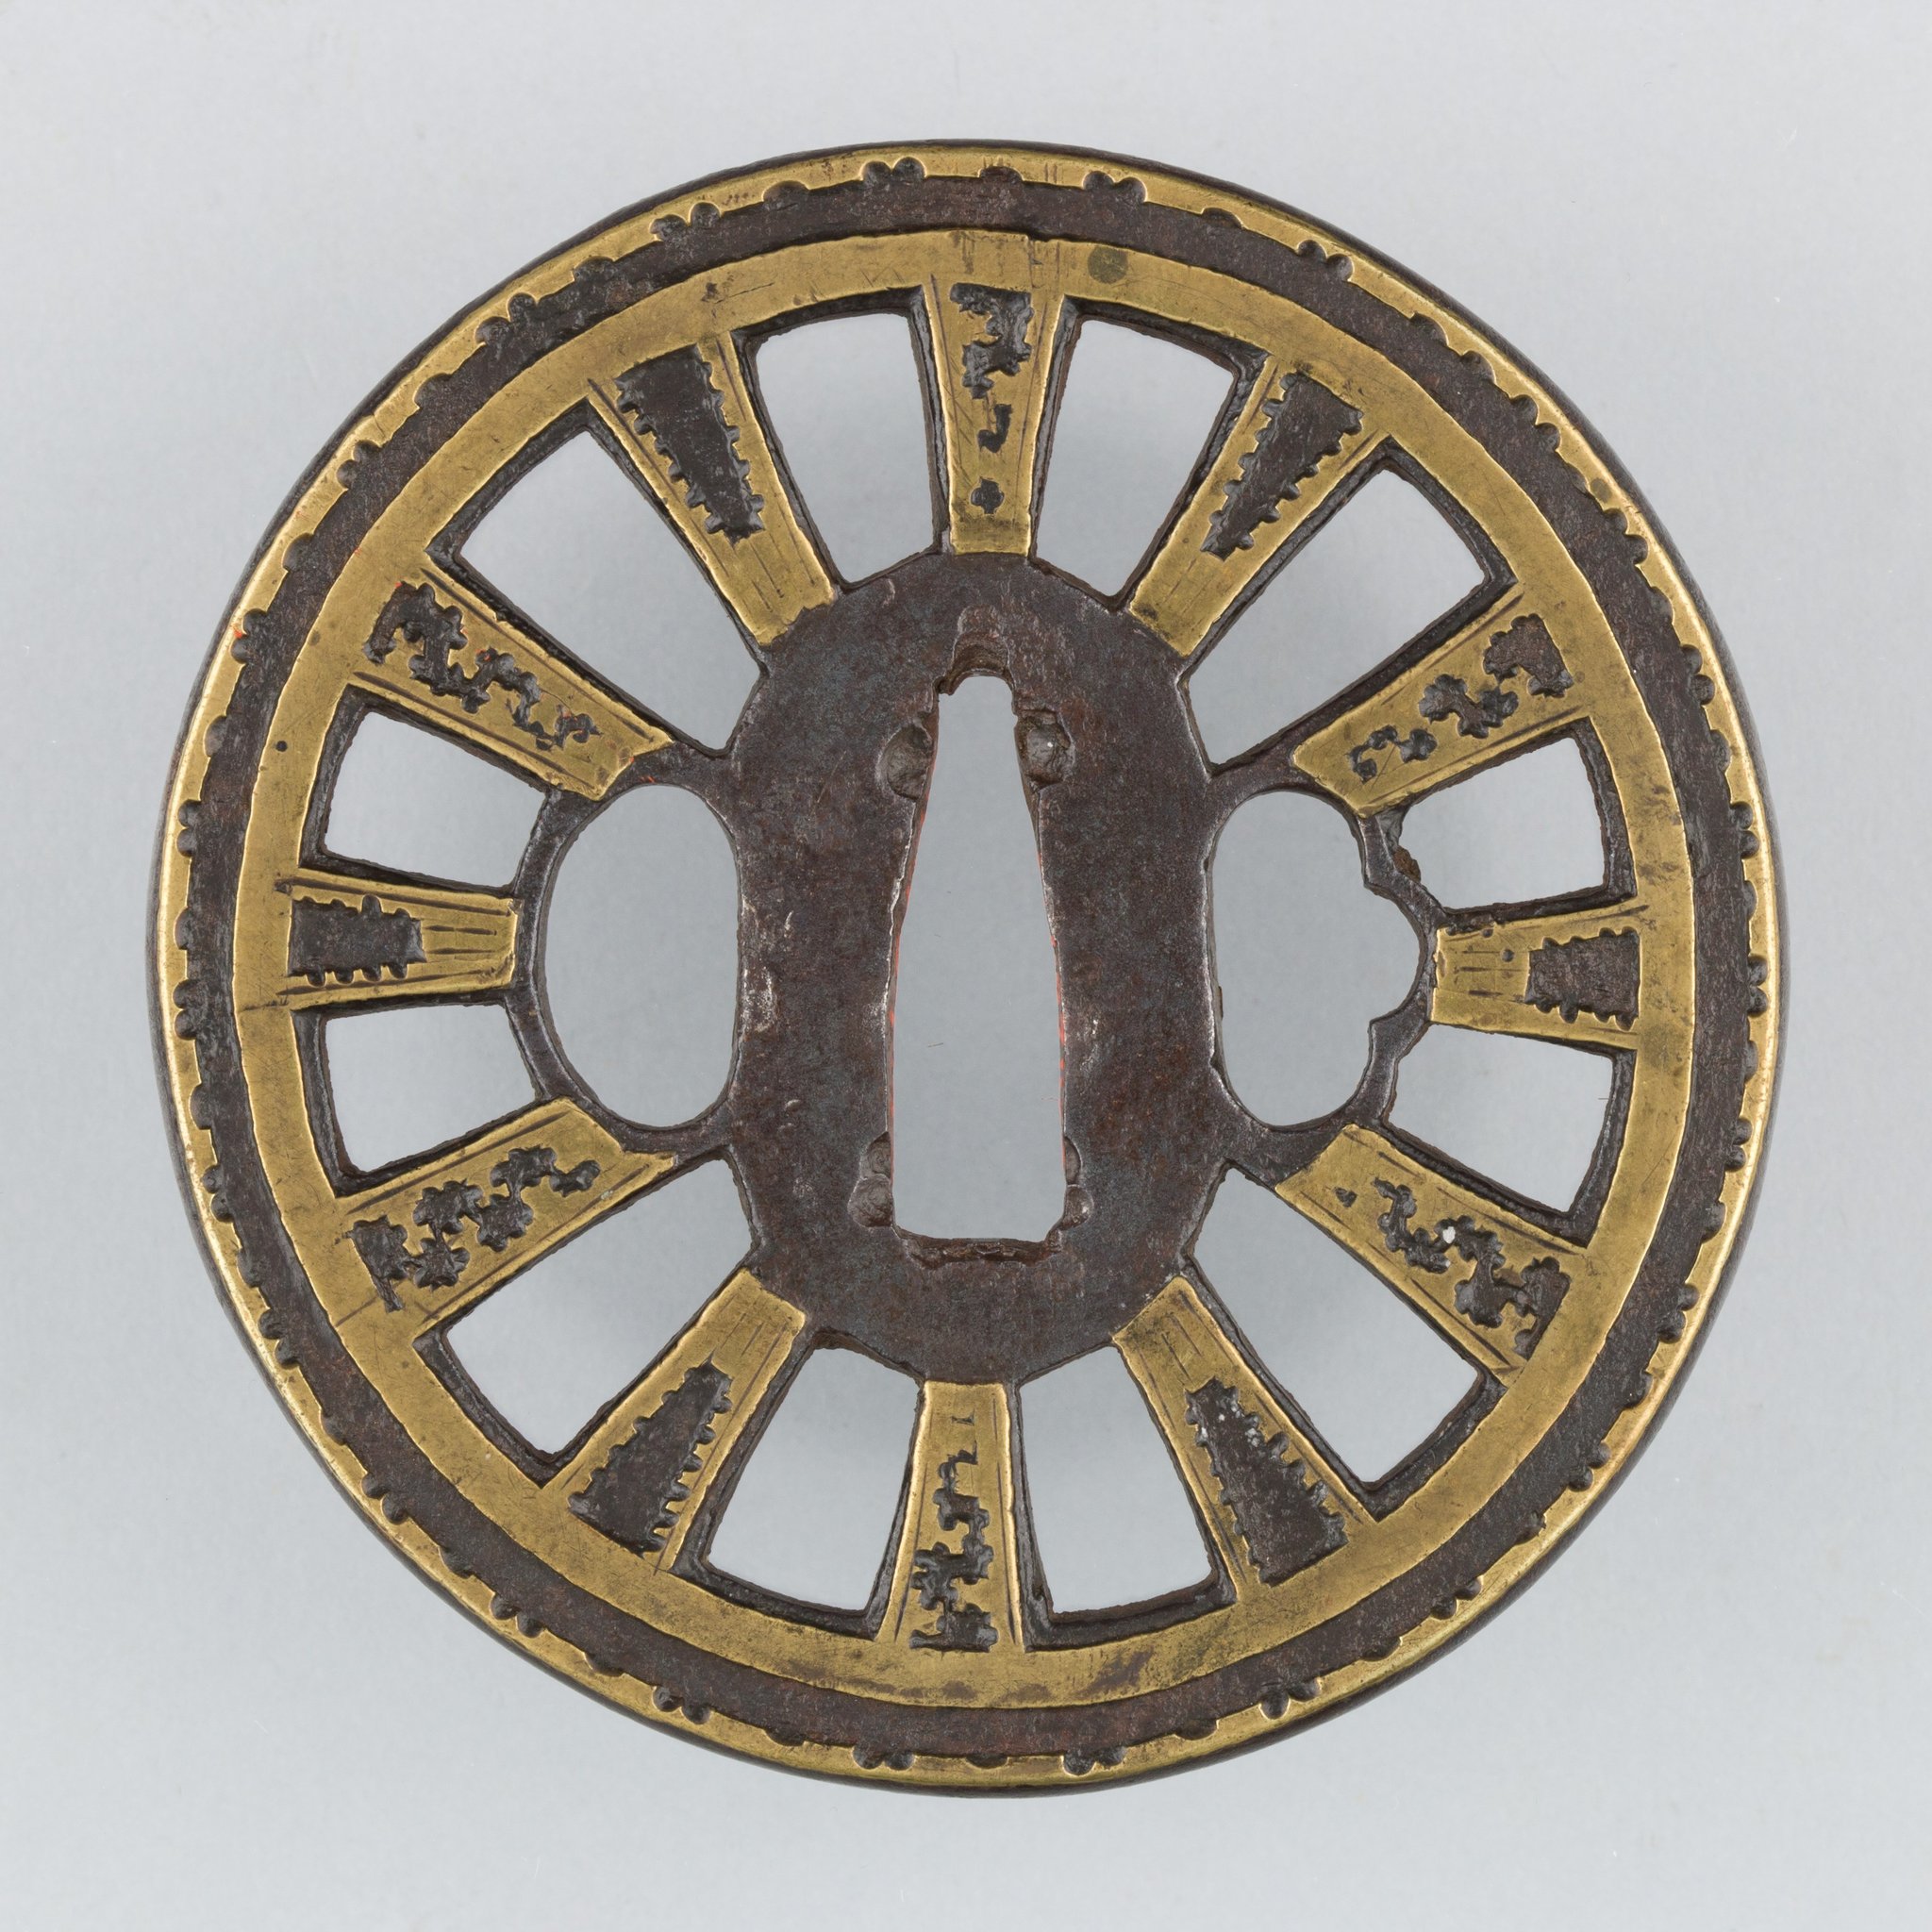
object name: sword guard tsuba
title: Sword Guard (Tsuba)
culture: japanese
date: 1601-1700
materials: brass, copper, iron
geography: japan